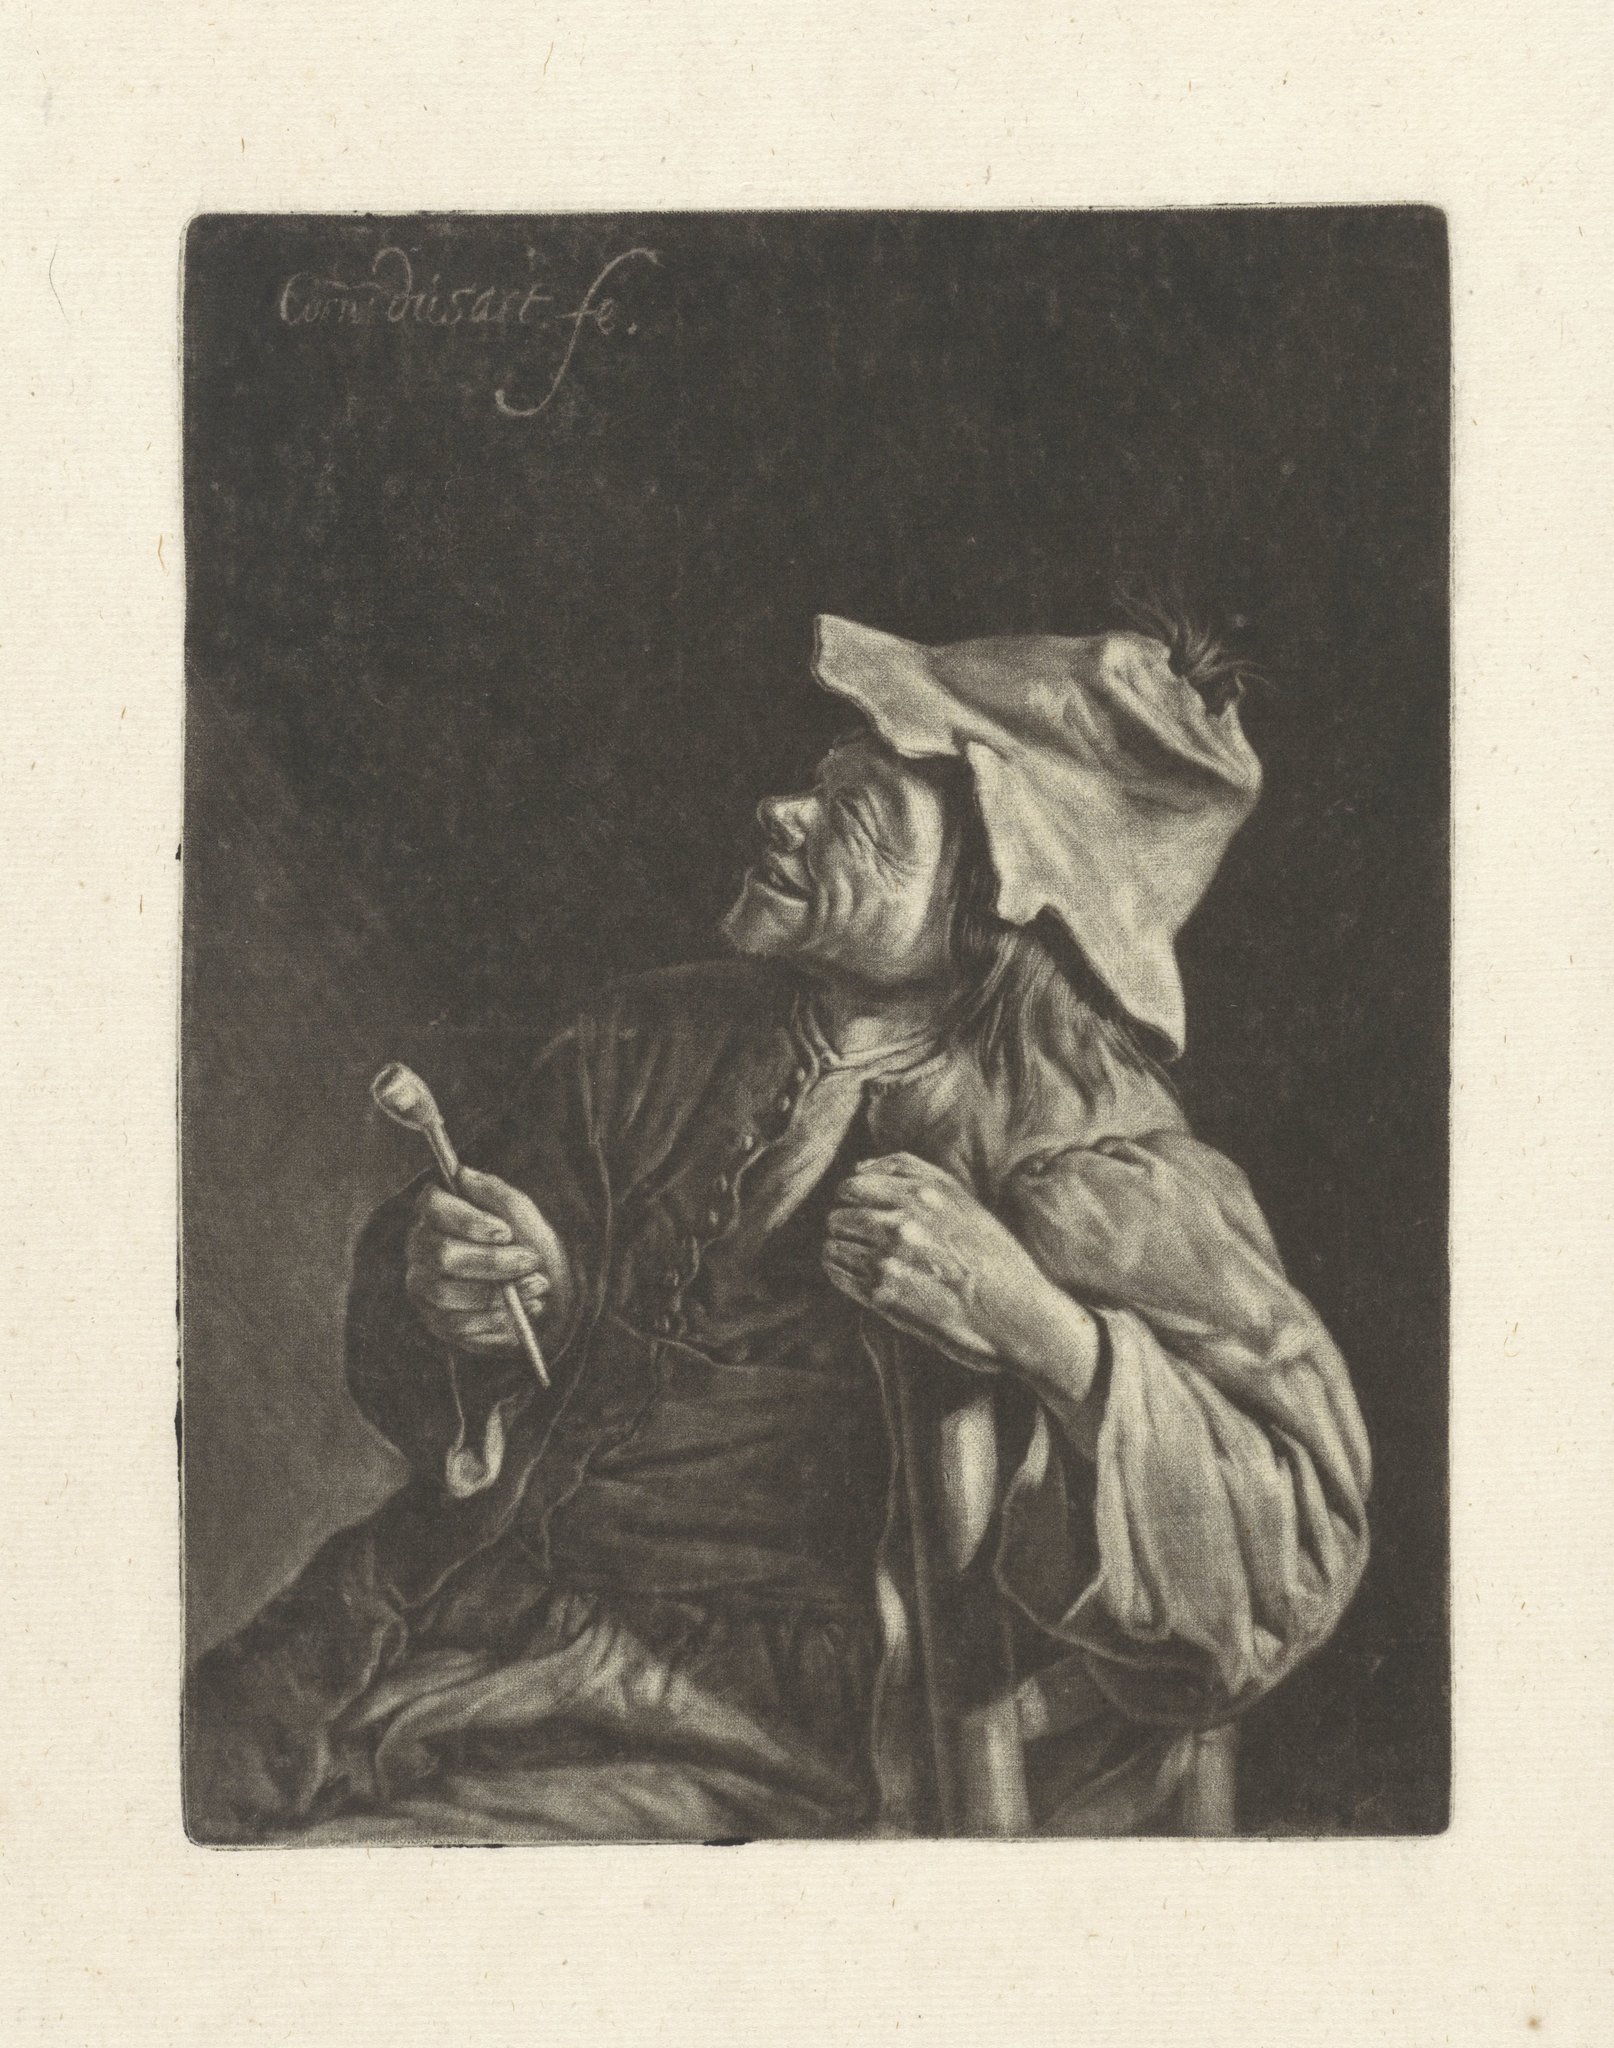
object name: print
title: Zittende boer met een pijp in de hand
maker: cornelis dusart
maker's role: draughtsman, painter, print maker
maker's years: 1660-1704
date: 1670-1704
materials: paper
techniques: mezzotint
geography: haarlem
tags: pipe ~ tobacco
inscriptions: collector's mark: Lugt 2228